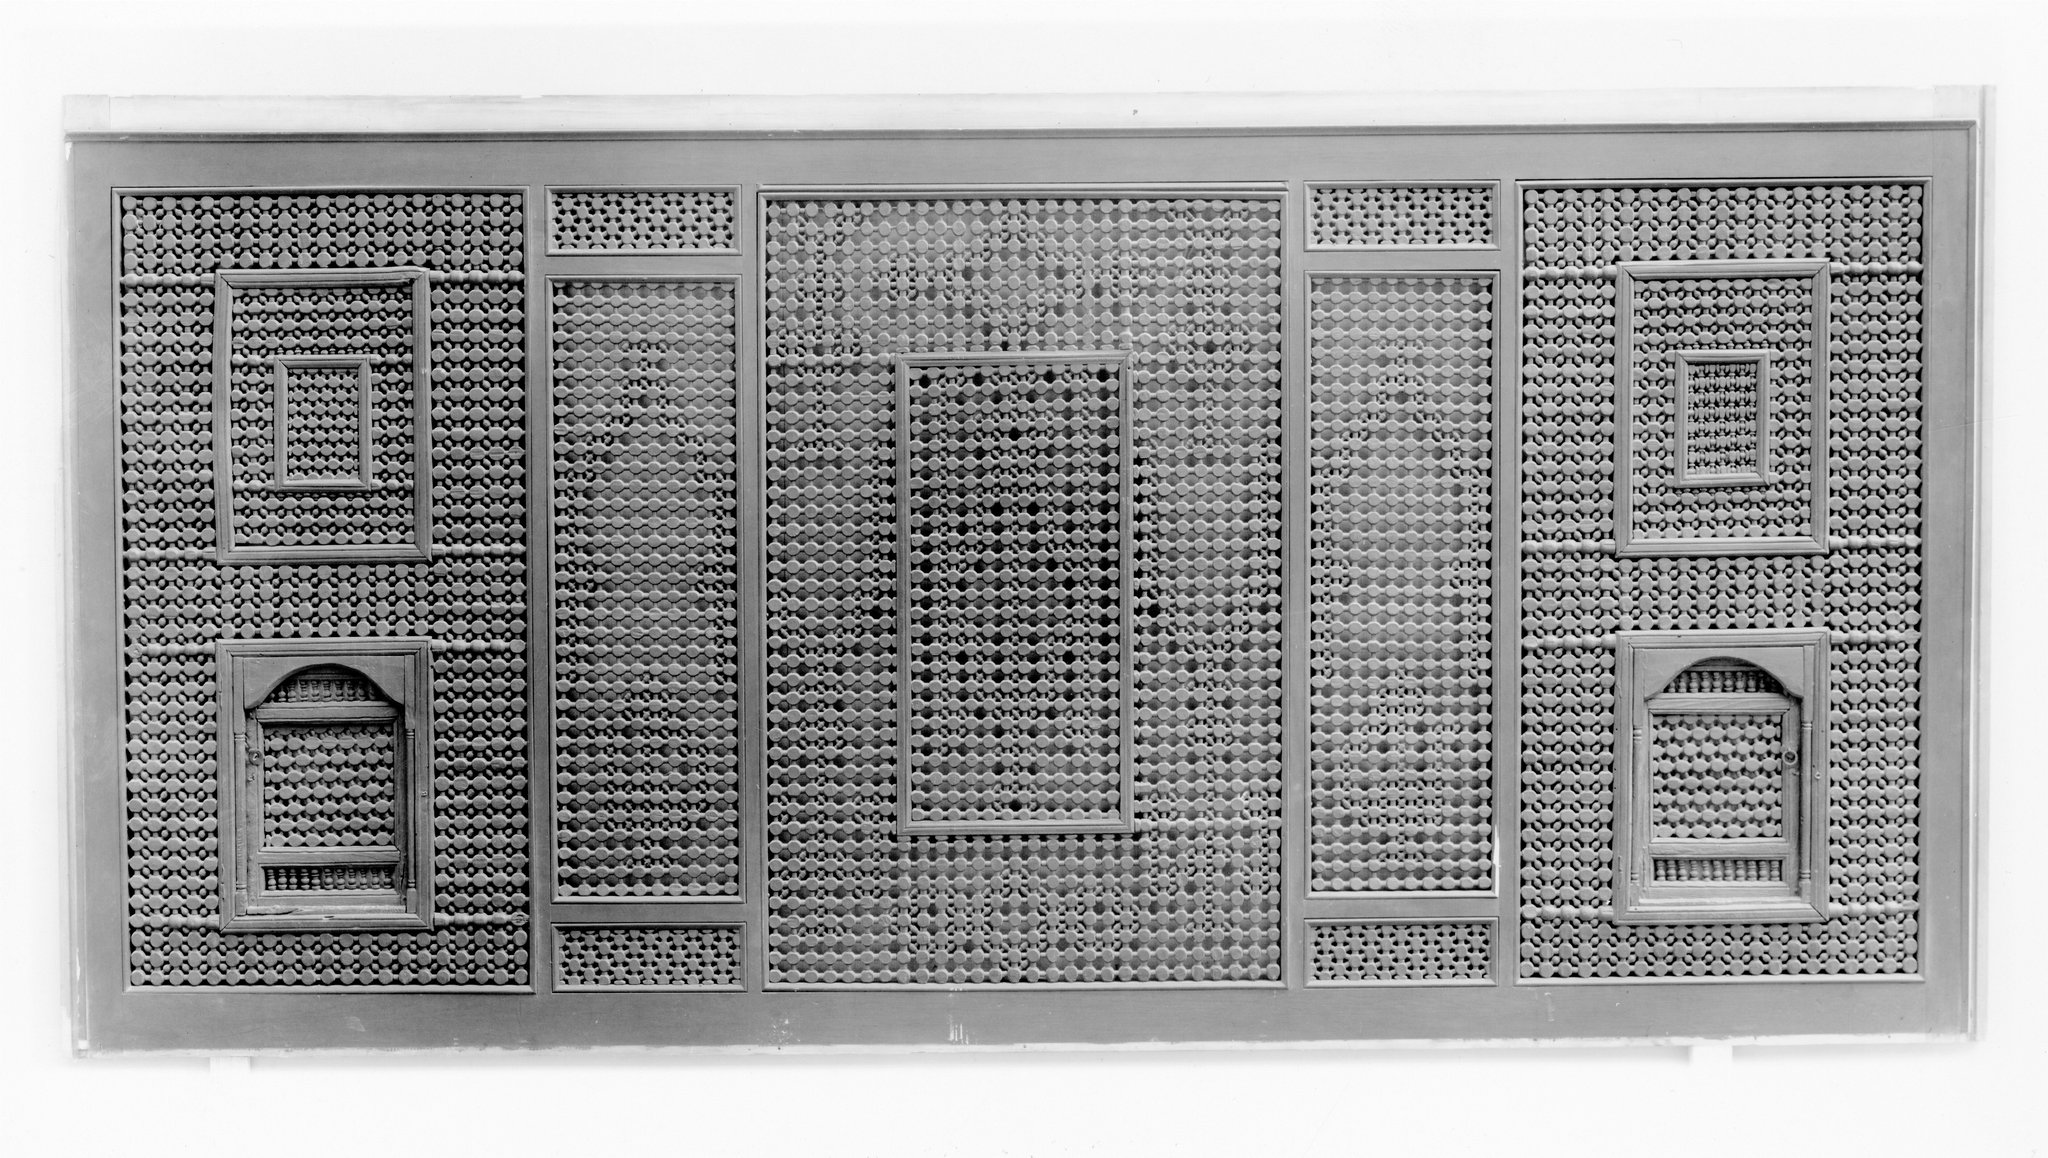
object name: screen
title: Mashrabiyya Screen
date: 1401-1600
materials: wood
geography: egypt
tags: screens